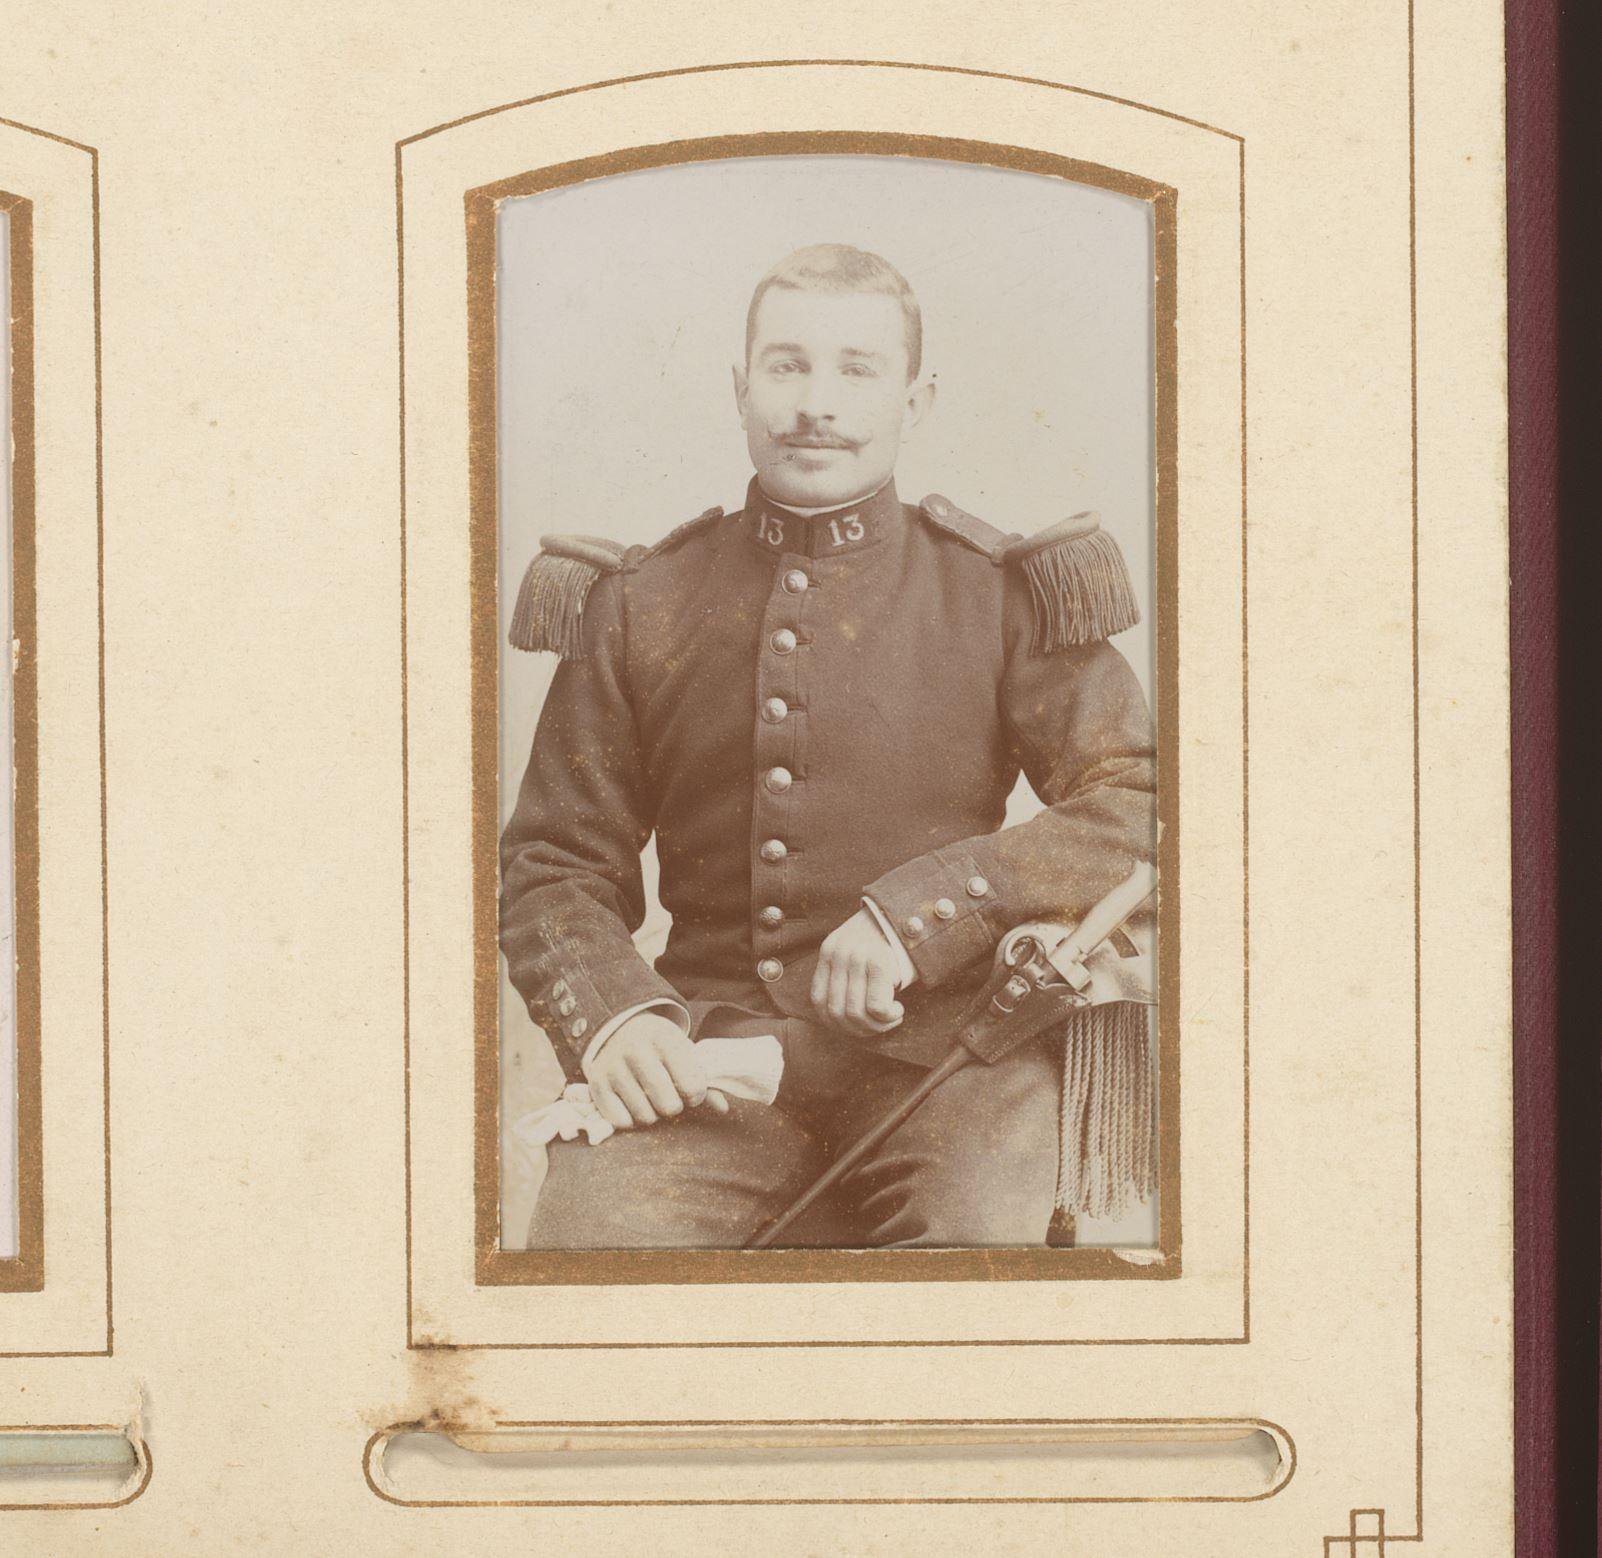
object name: photograph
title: Portret van een man in uniform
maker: c. bick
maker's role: fotograaf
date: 1880-1920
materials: cardboard, photographic support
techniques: collodion silver print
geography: decize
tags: historical persons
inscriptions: inscription: ‘Abel Lachambre/ Photographe/ a Decize/ Ch. Bick, Succsseur’